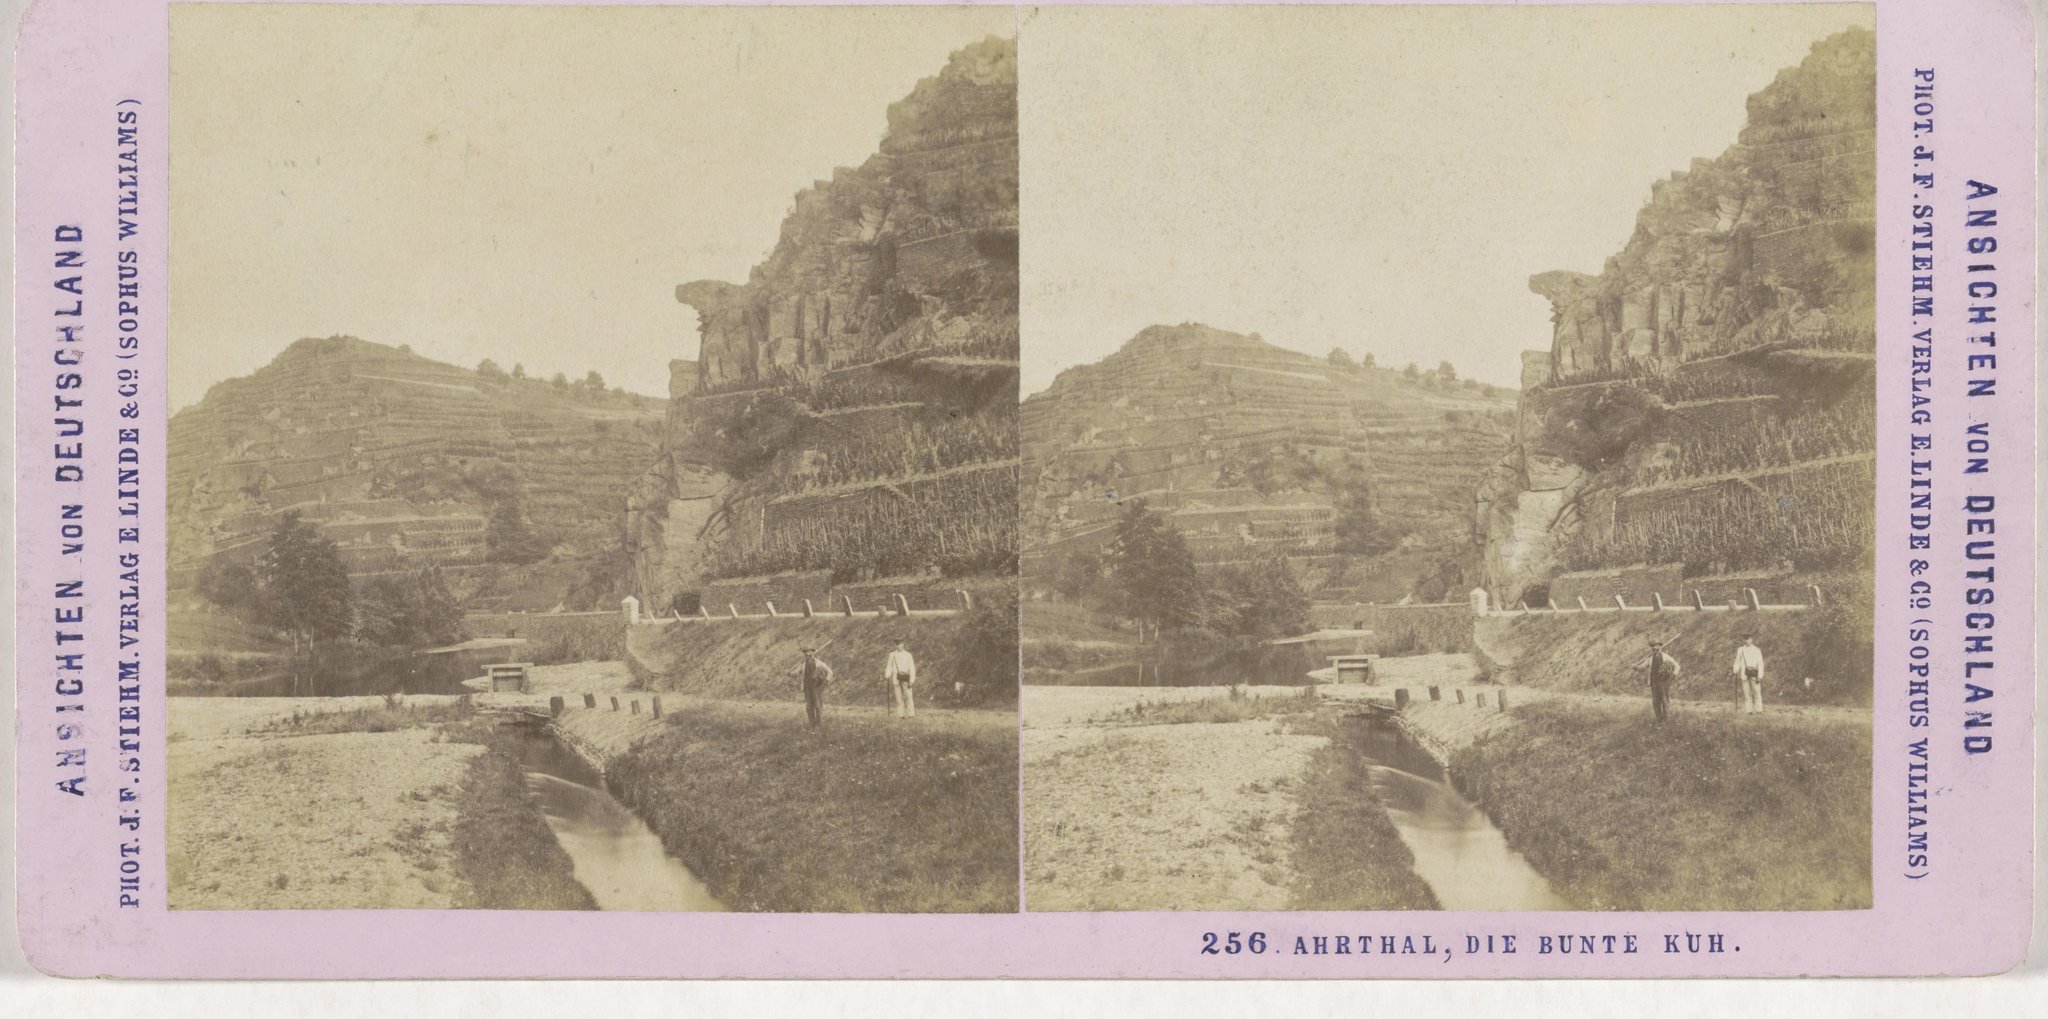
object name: stereograph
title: Ansichten von Deutschland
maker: johann friedrich stiehm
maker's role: fotograaf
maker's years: 1826-1902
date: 1869-1872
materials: cardboard, paper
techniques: albumen print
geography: berlin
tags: rock-formations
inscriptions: number: ‘256.’